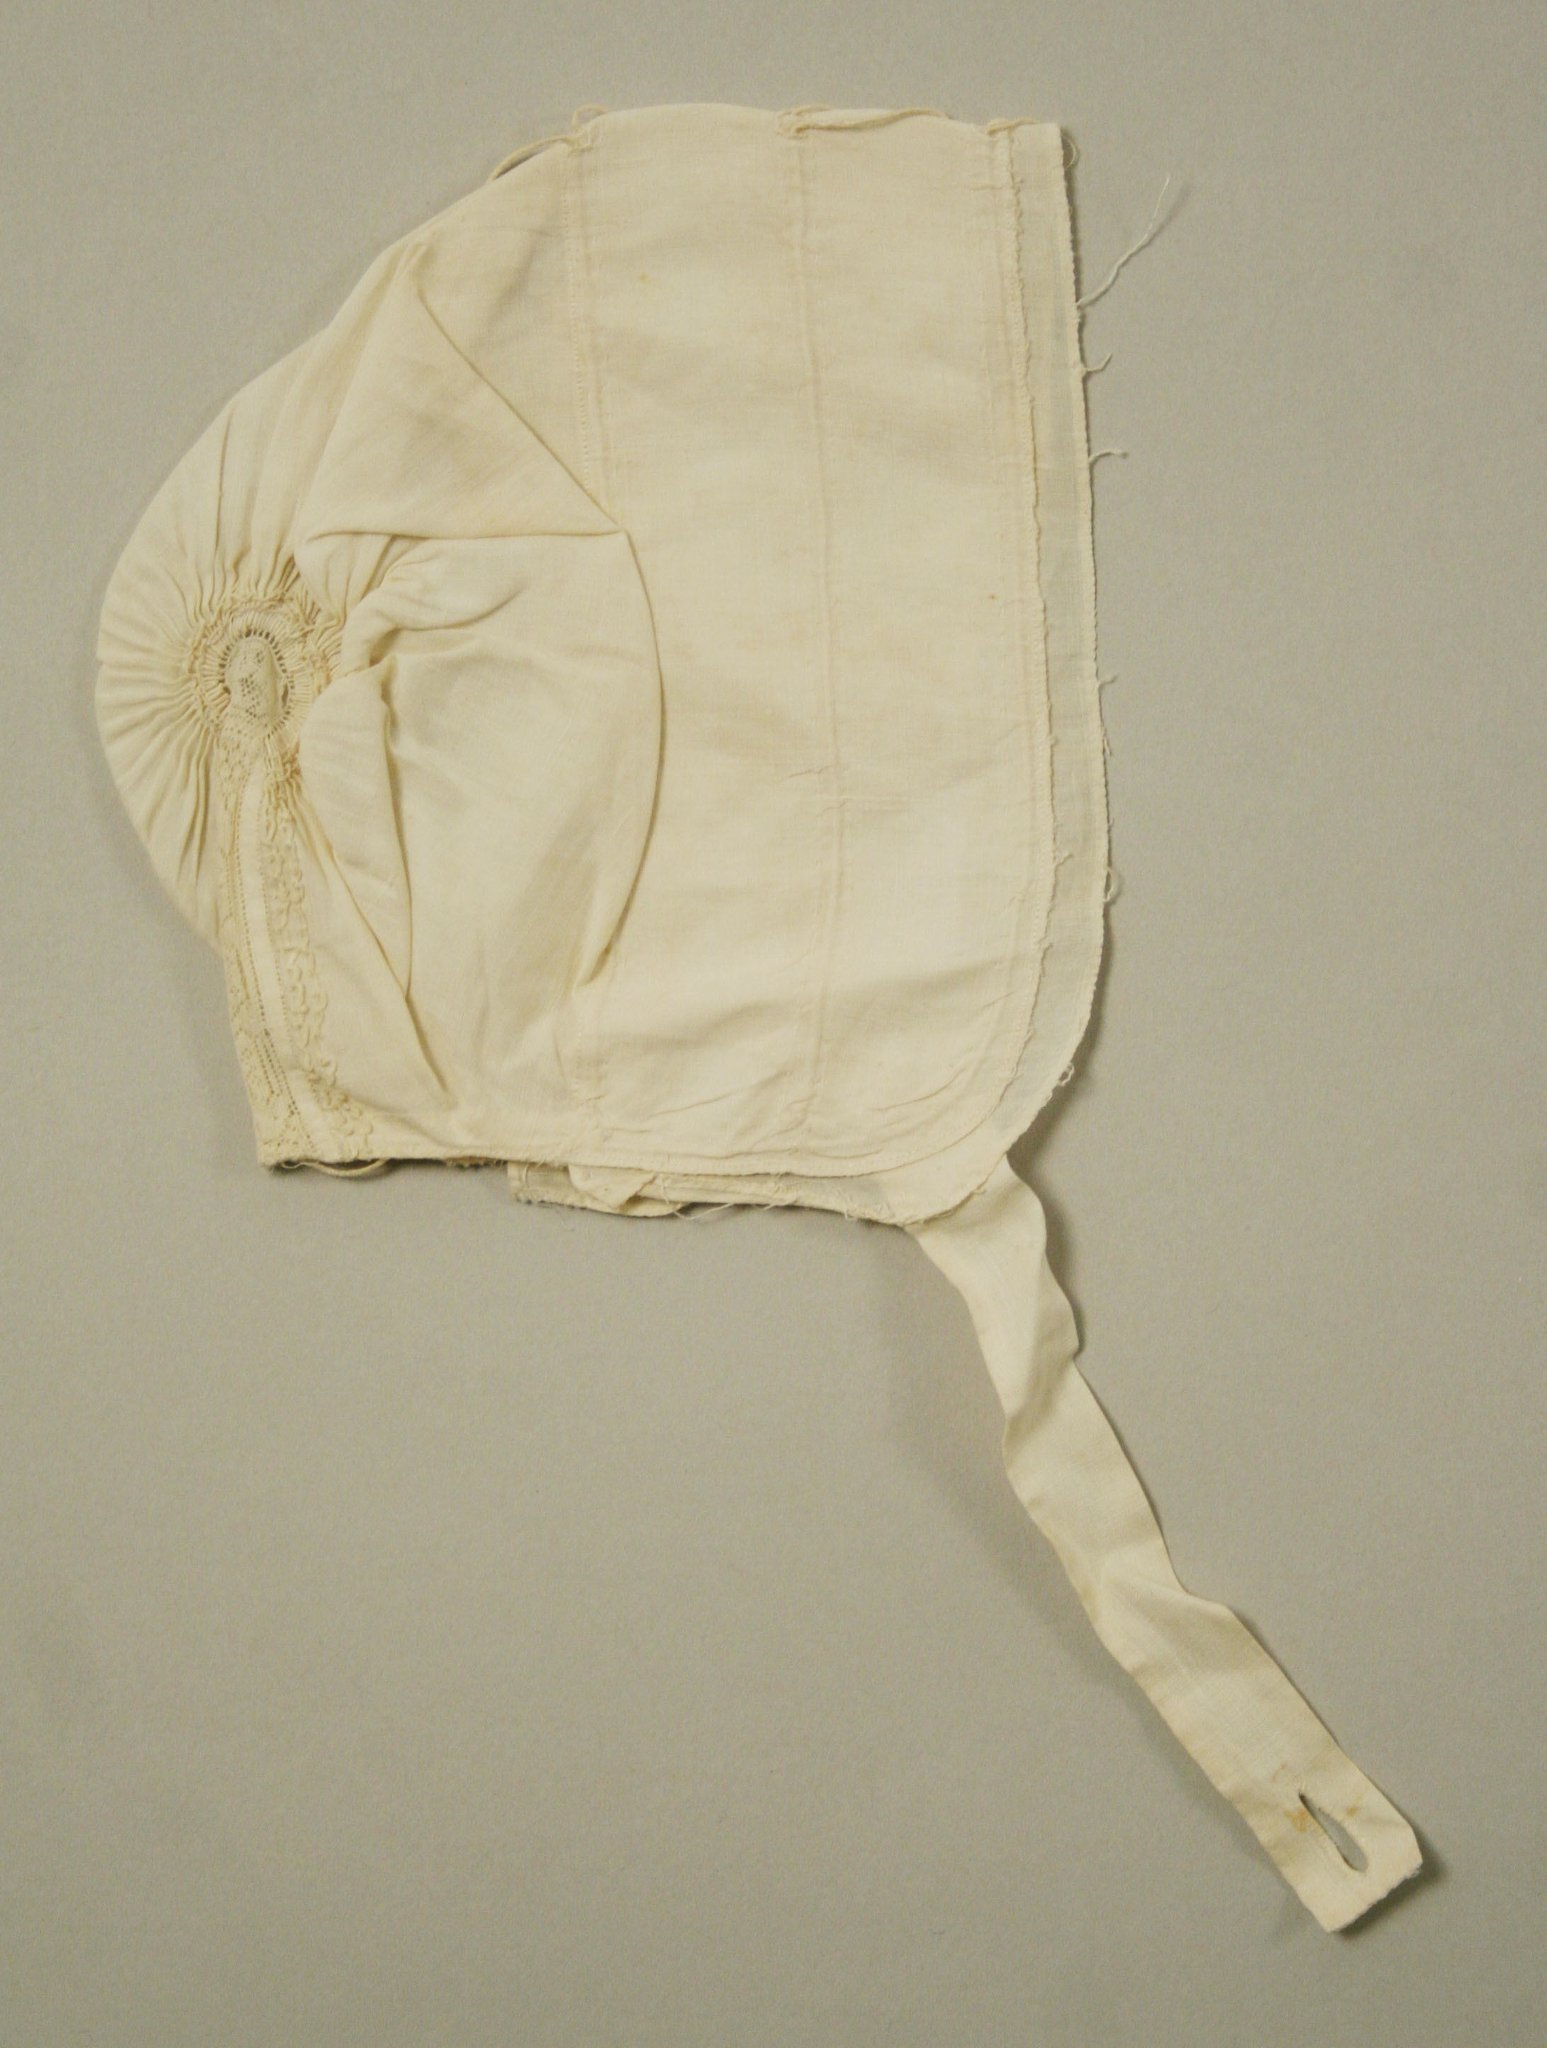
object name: cap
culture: british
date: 1701-1800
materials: linen